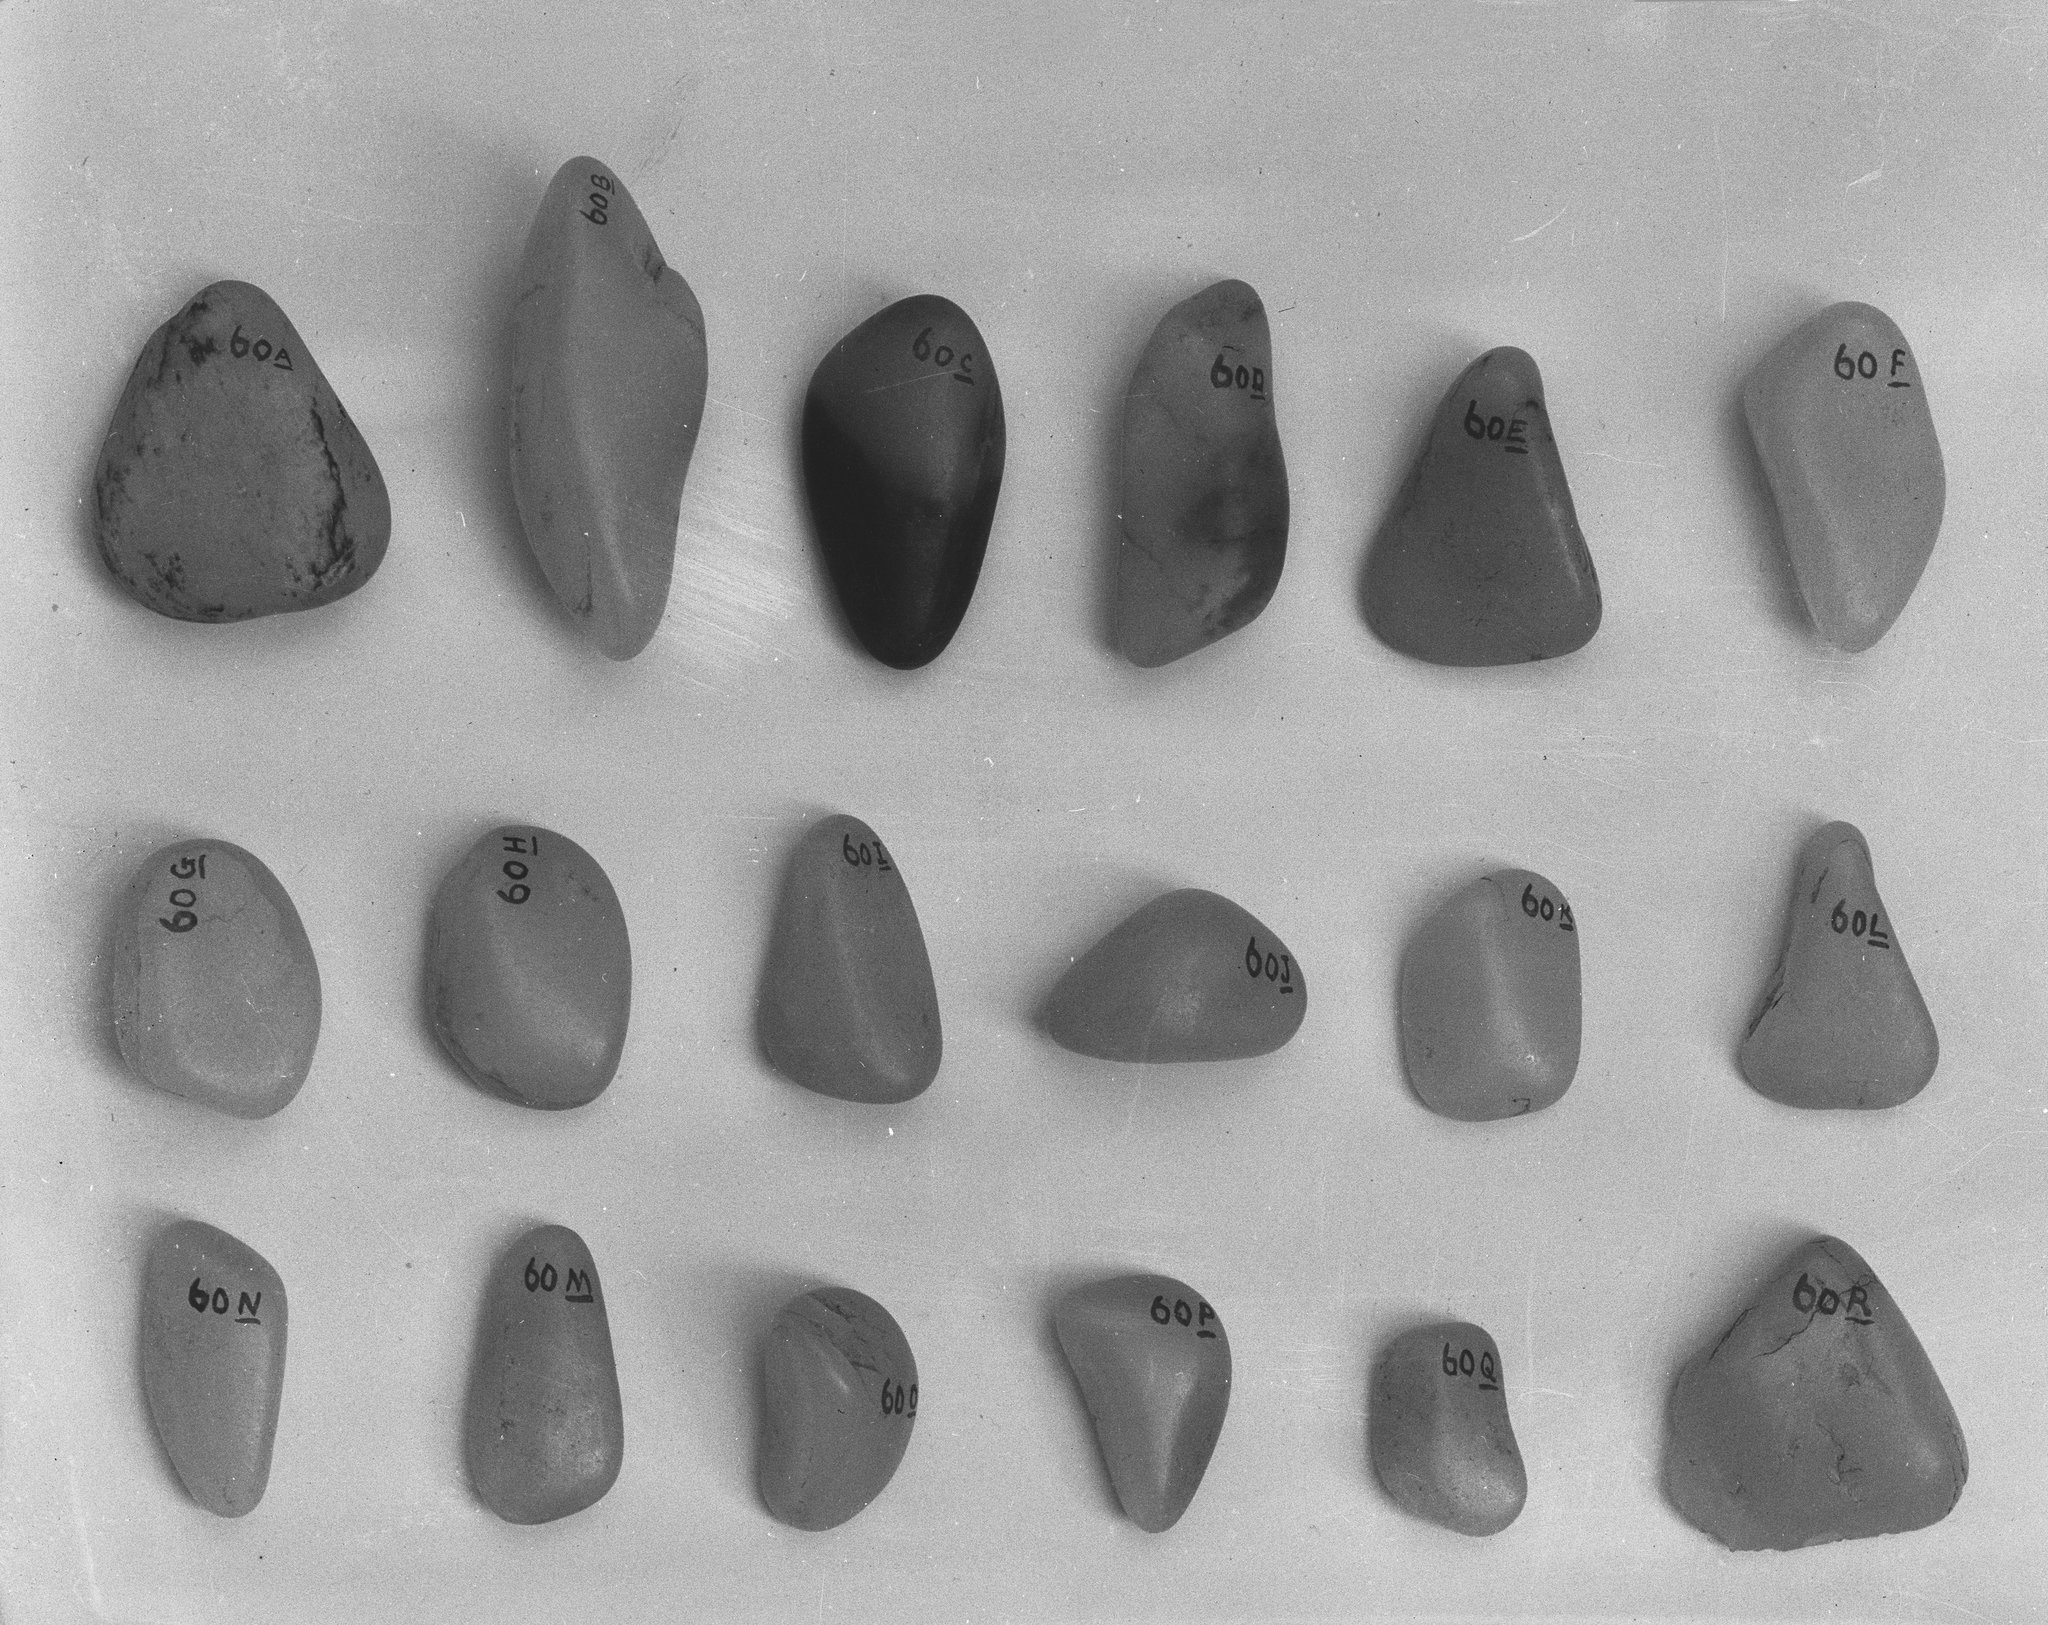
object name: pebble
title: Eighteen Pebbles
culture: chinese or turkestani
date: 1902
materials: jade